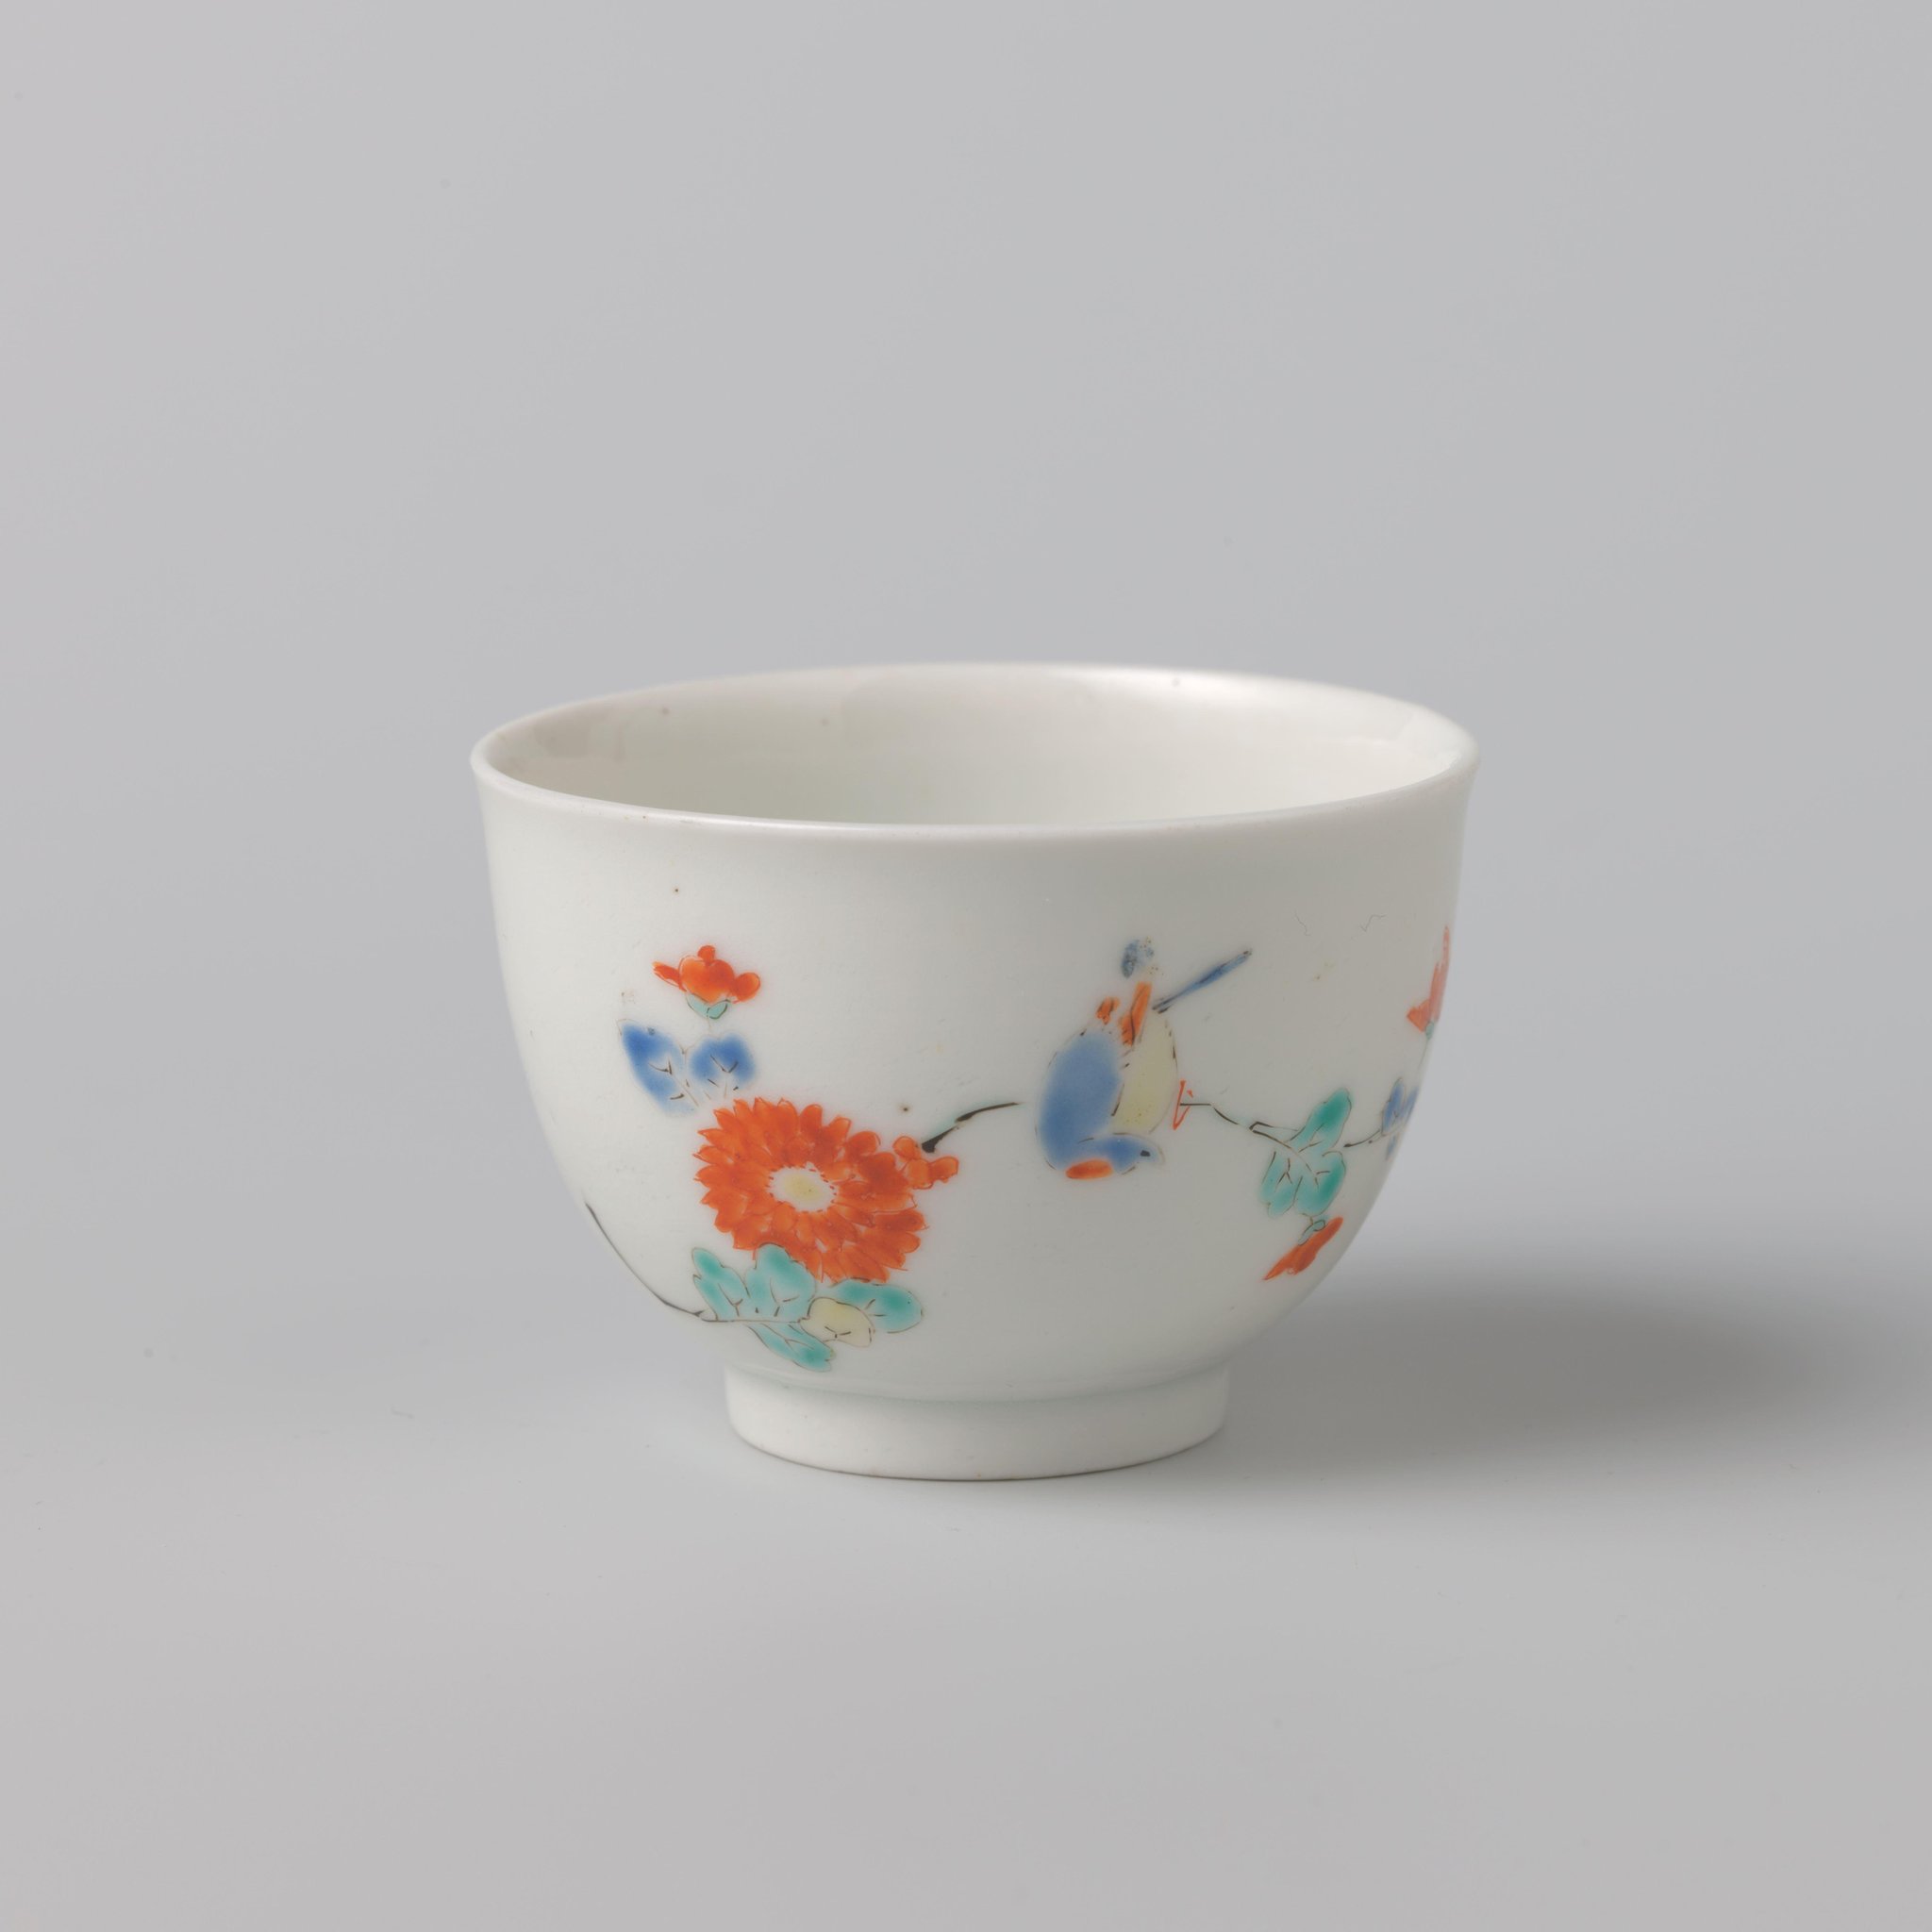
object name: cup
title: Round cup with flower spray and bird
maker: Anonymous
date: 1670-1700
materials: glaze, paint, porcelain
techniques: firing, turning, vitrification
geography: arita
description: Ronde kop en van porselein, beschilderd op het glazuur in blauw, rood, groen, geel en zwart, met op de kop een vogel met chrysanttakken, op de schotel een vogel in een prunustak bij rotsen en water. Bakscheur in voetring kop. Kop hoort waarschijnlijk niet bij schotel, gezien het verschil in de kleuren rood en geel. Kakiemon-stijl.